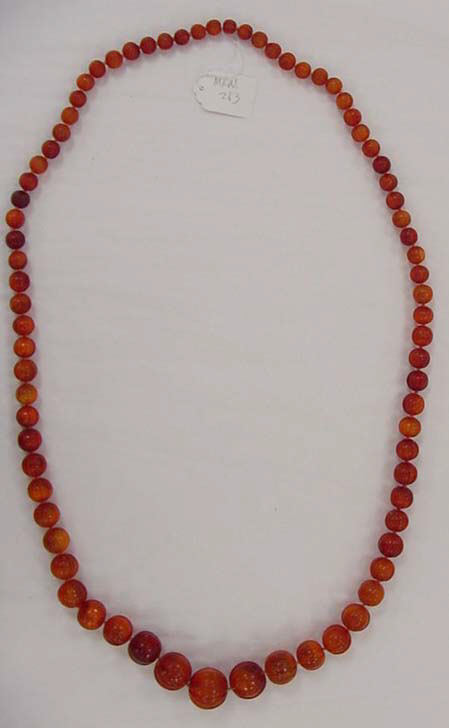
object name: necklace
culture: chinese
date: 1368-1644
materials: amber, cotton